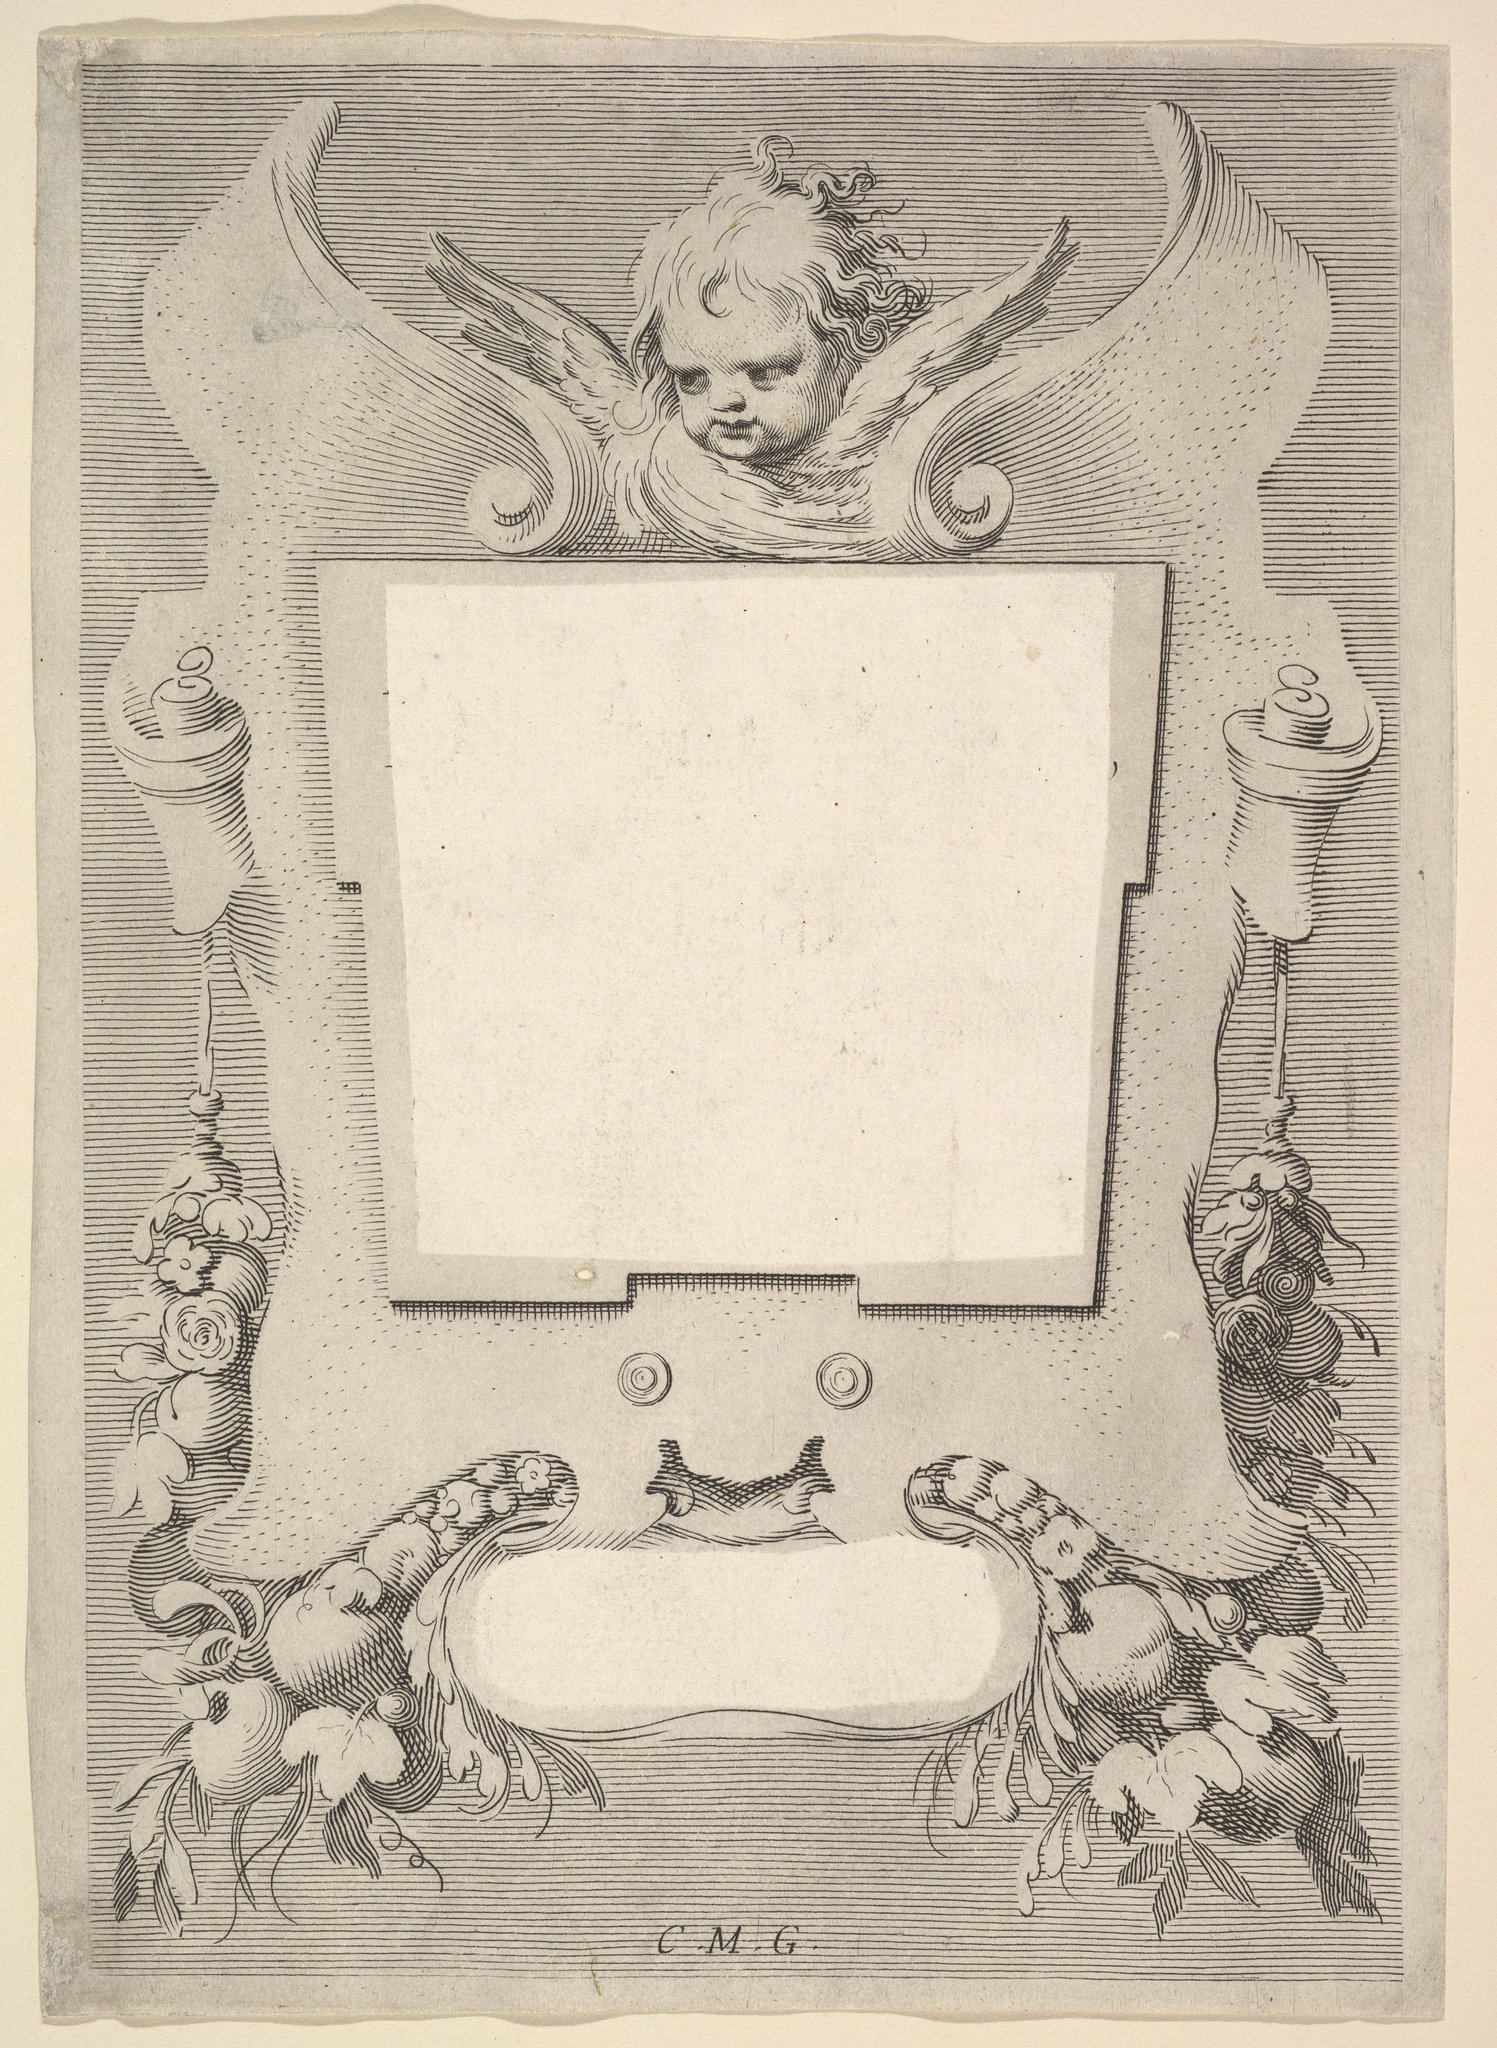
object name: print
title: Title Page: Bentivoglio, Della Guerra di Fiandra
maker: claude mellan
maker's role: artist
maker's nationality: french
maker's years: 1598-1688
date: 1632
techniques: engraving, printing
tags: flowers,roses